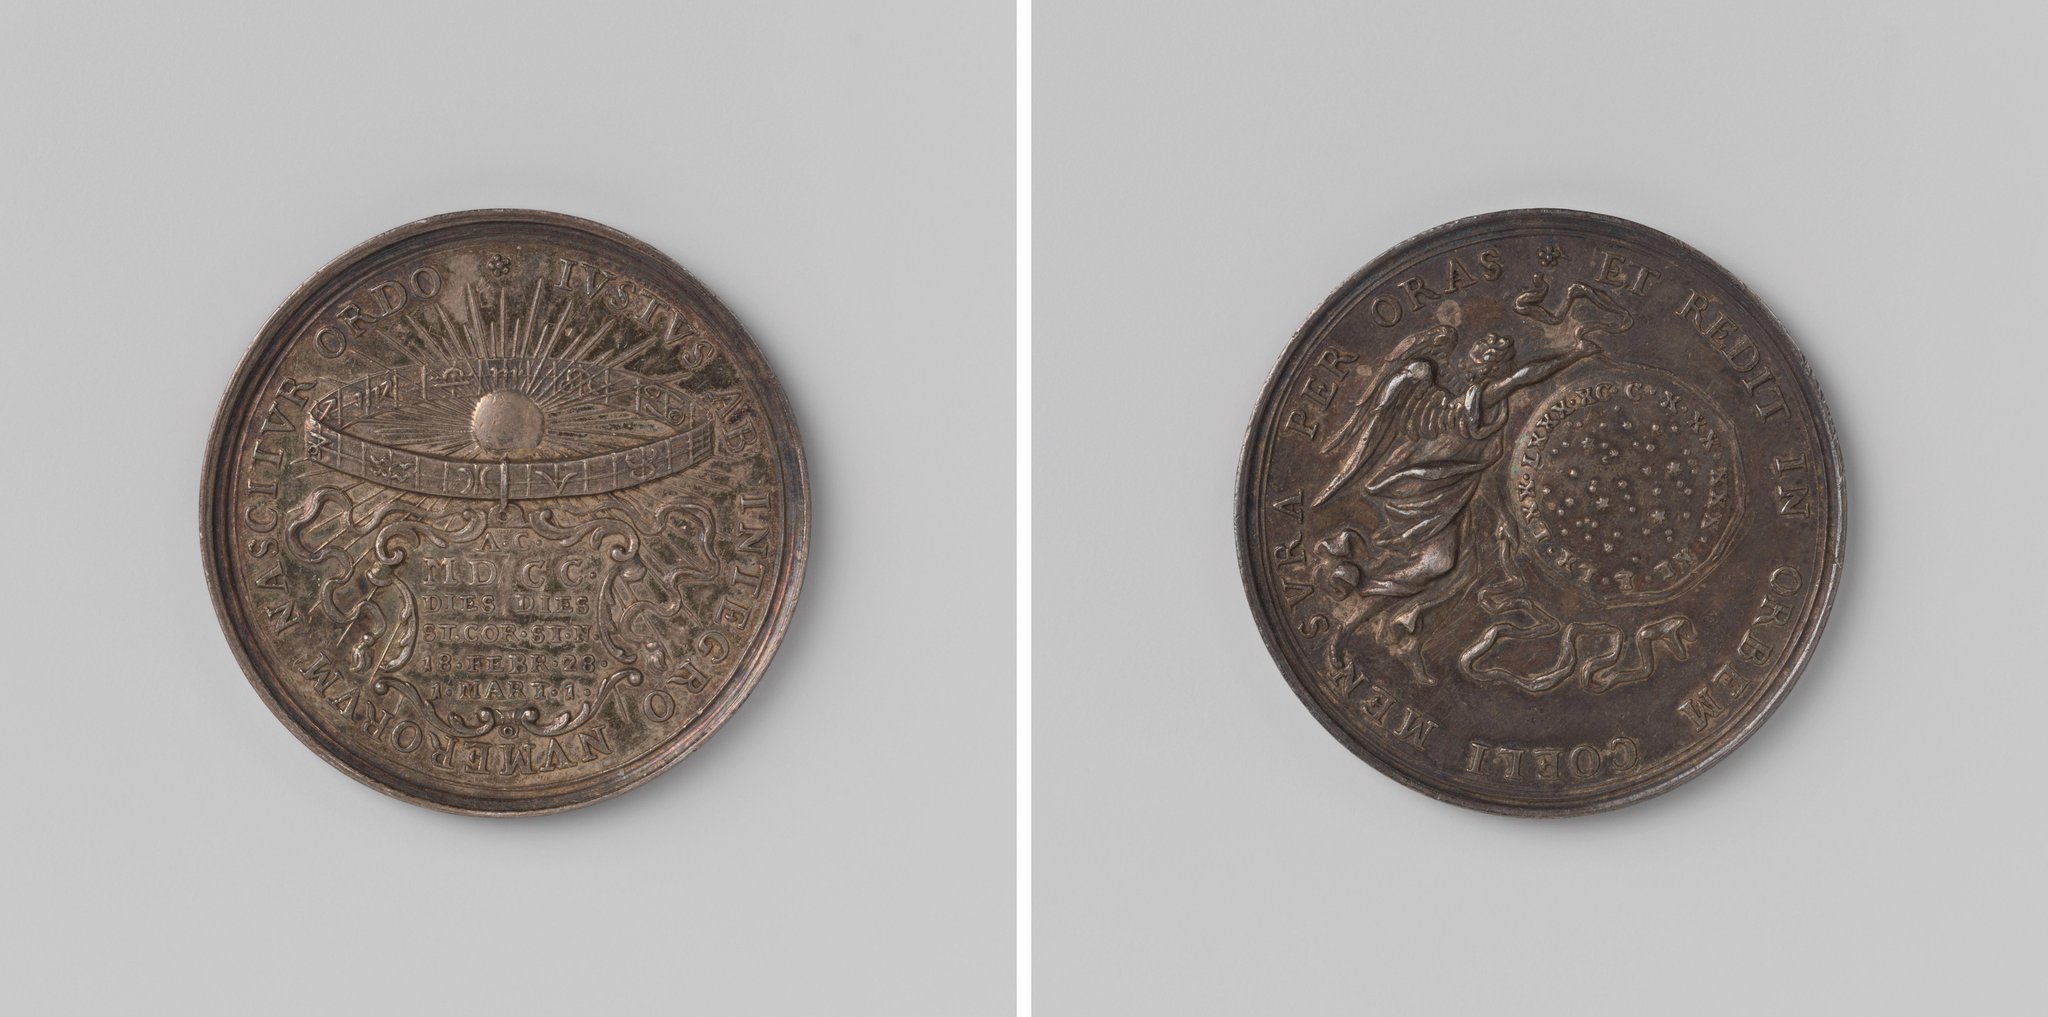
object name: history medal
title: Invoering van de Gregoriaanse tijdrekening door de protestantse, Duitse vorsten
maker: Anonymous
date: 1700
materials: silver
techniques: striking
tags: germany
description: Zilveren penning. Voorzijde: zon en ring met tekens van dierenriem boven cartouche met opschrift binnen omschrift. Keerzijde: engel houdt sluier om sterrenhemel binnen omschrift